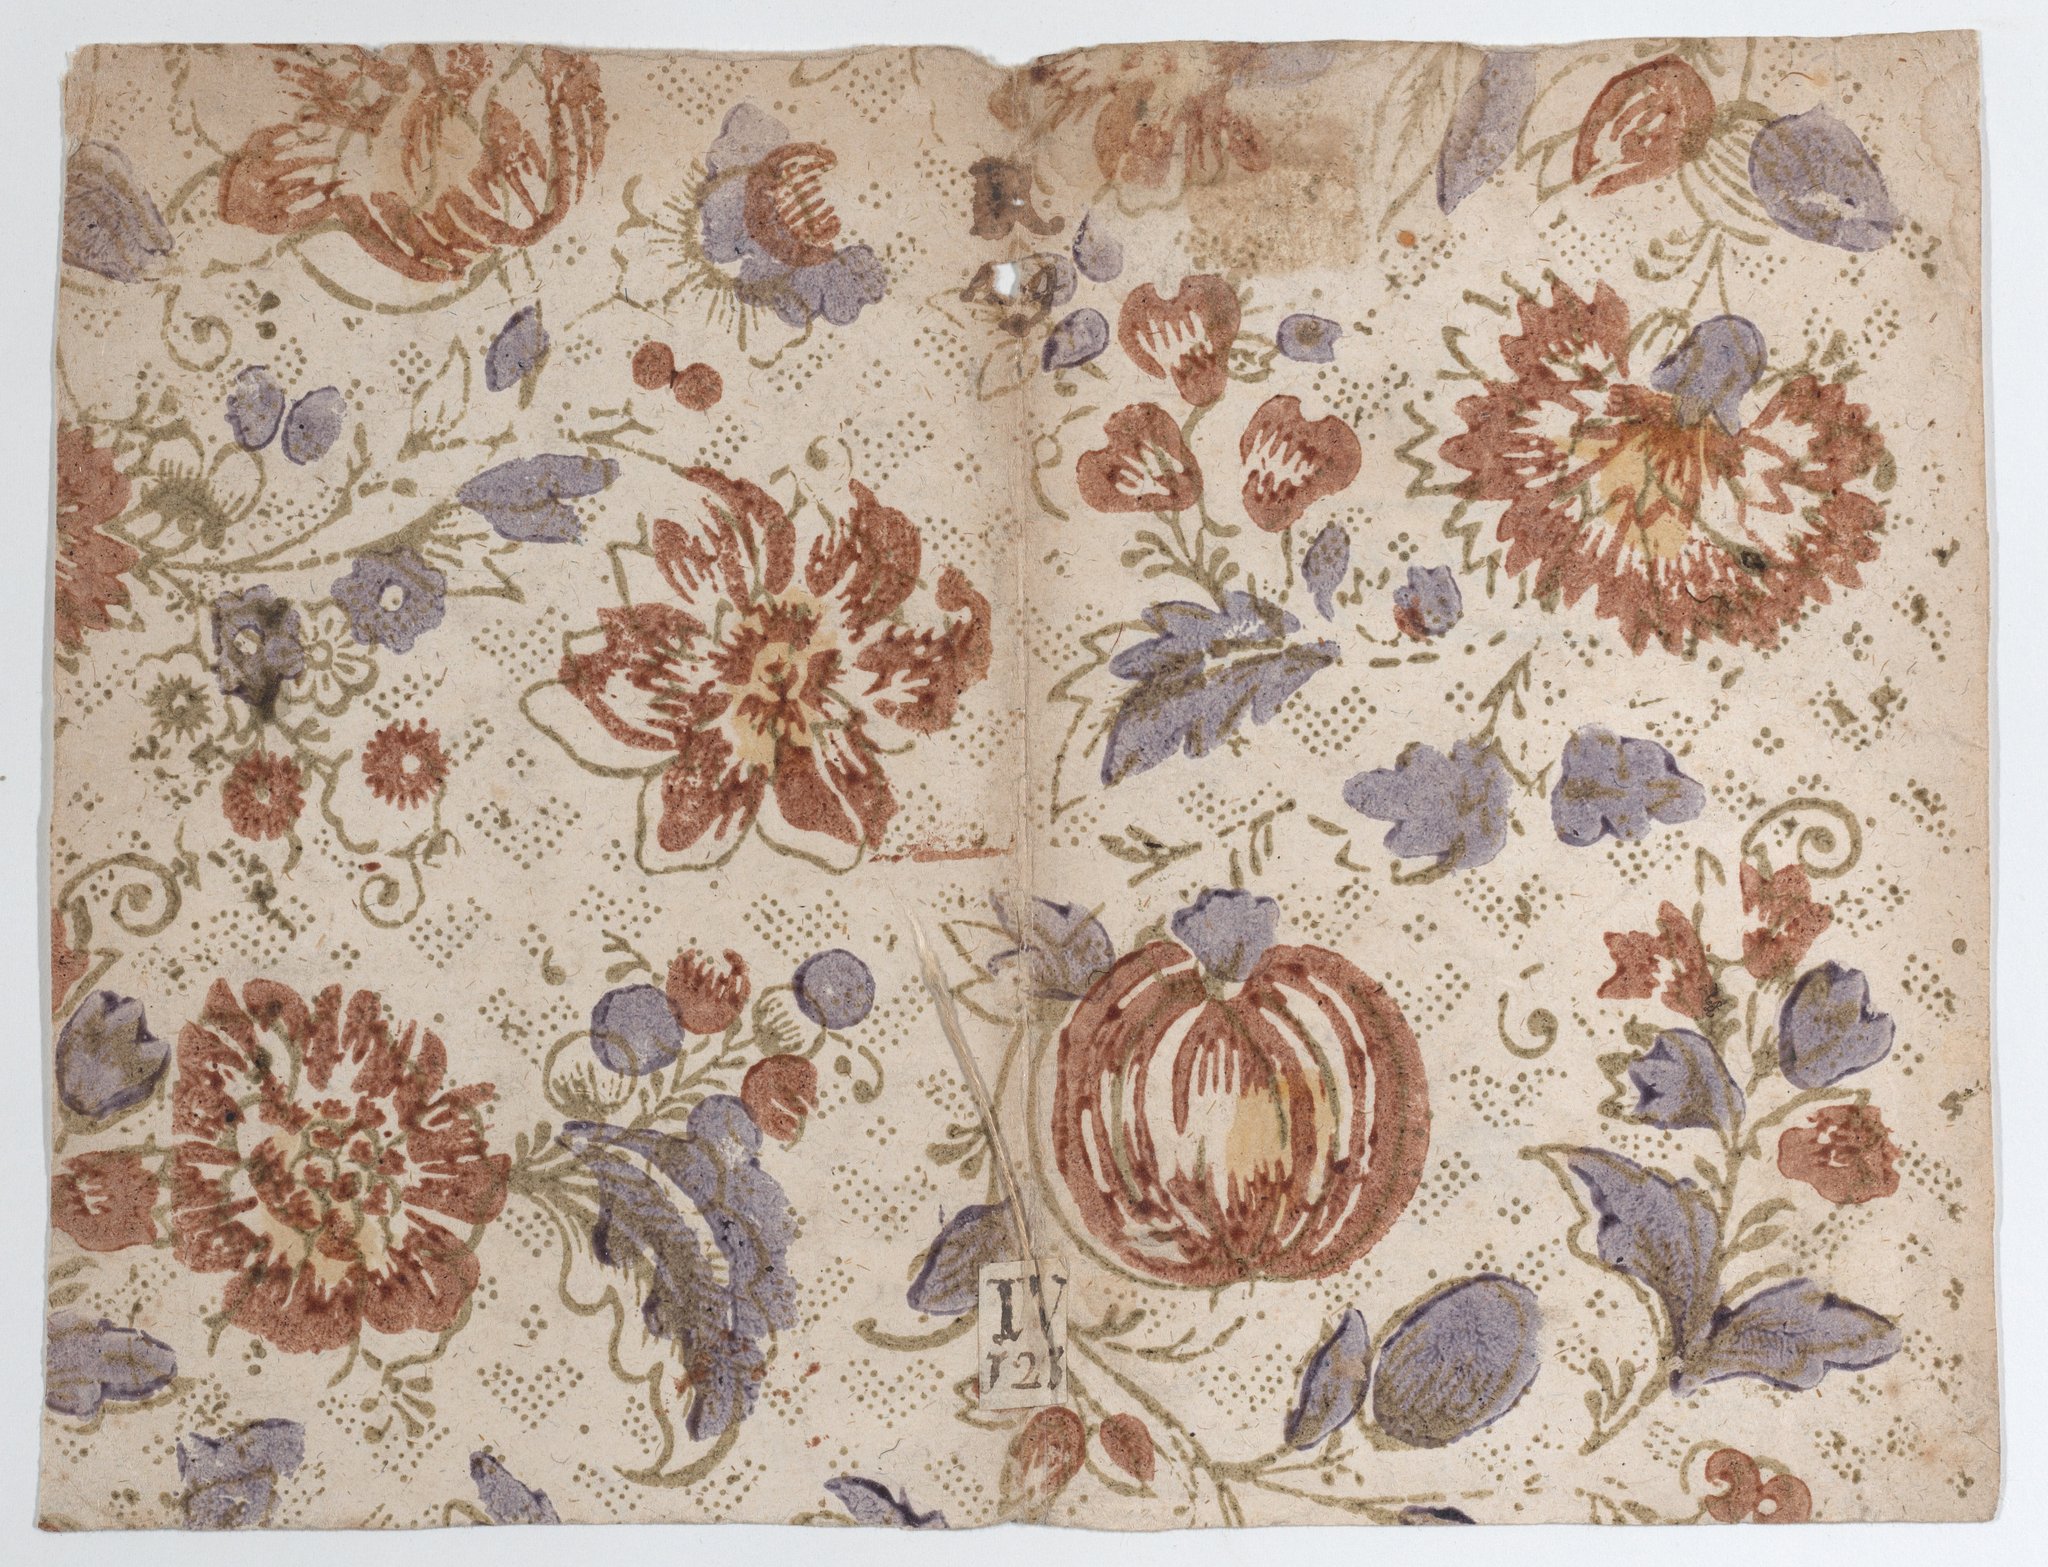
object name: print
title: Book cover with overall circular pattern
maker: Anonymous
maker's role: artist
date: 1701-1800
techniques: relief print